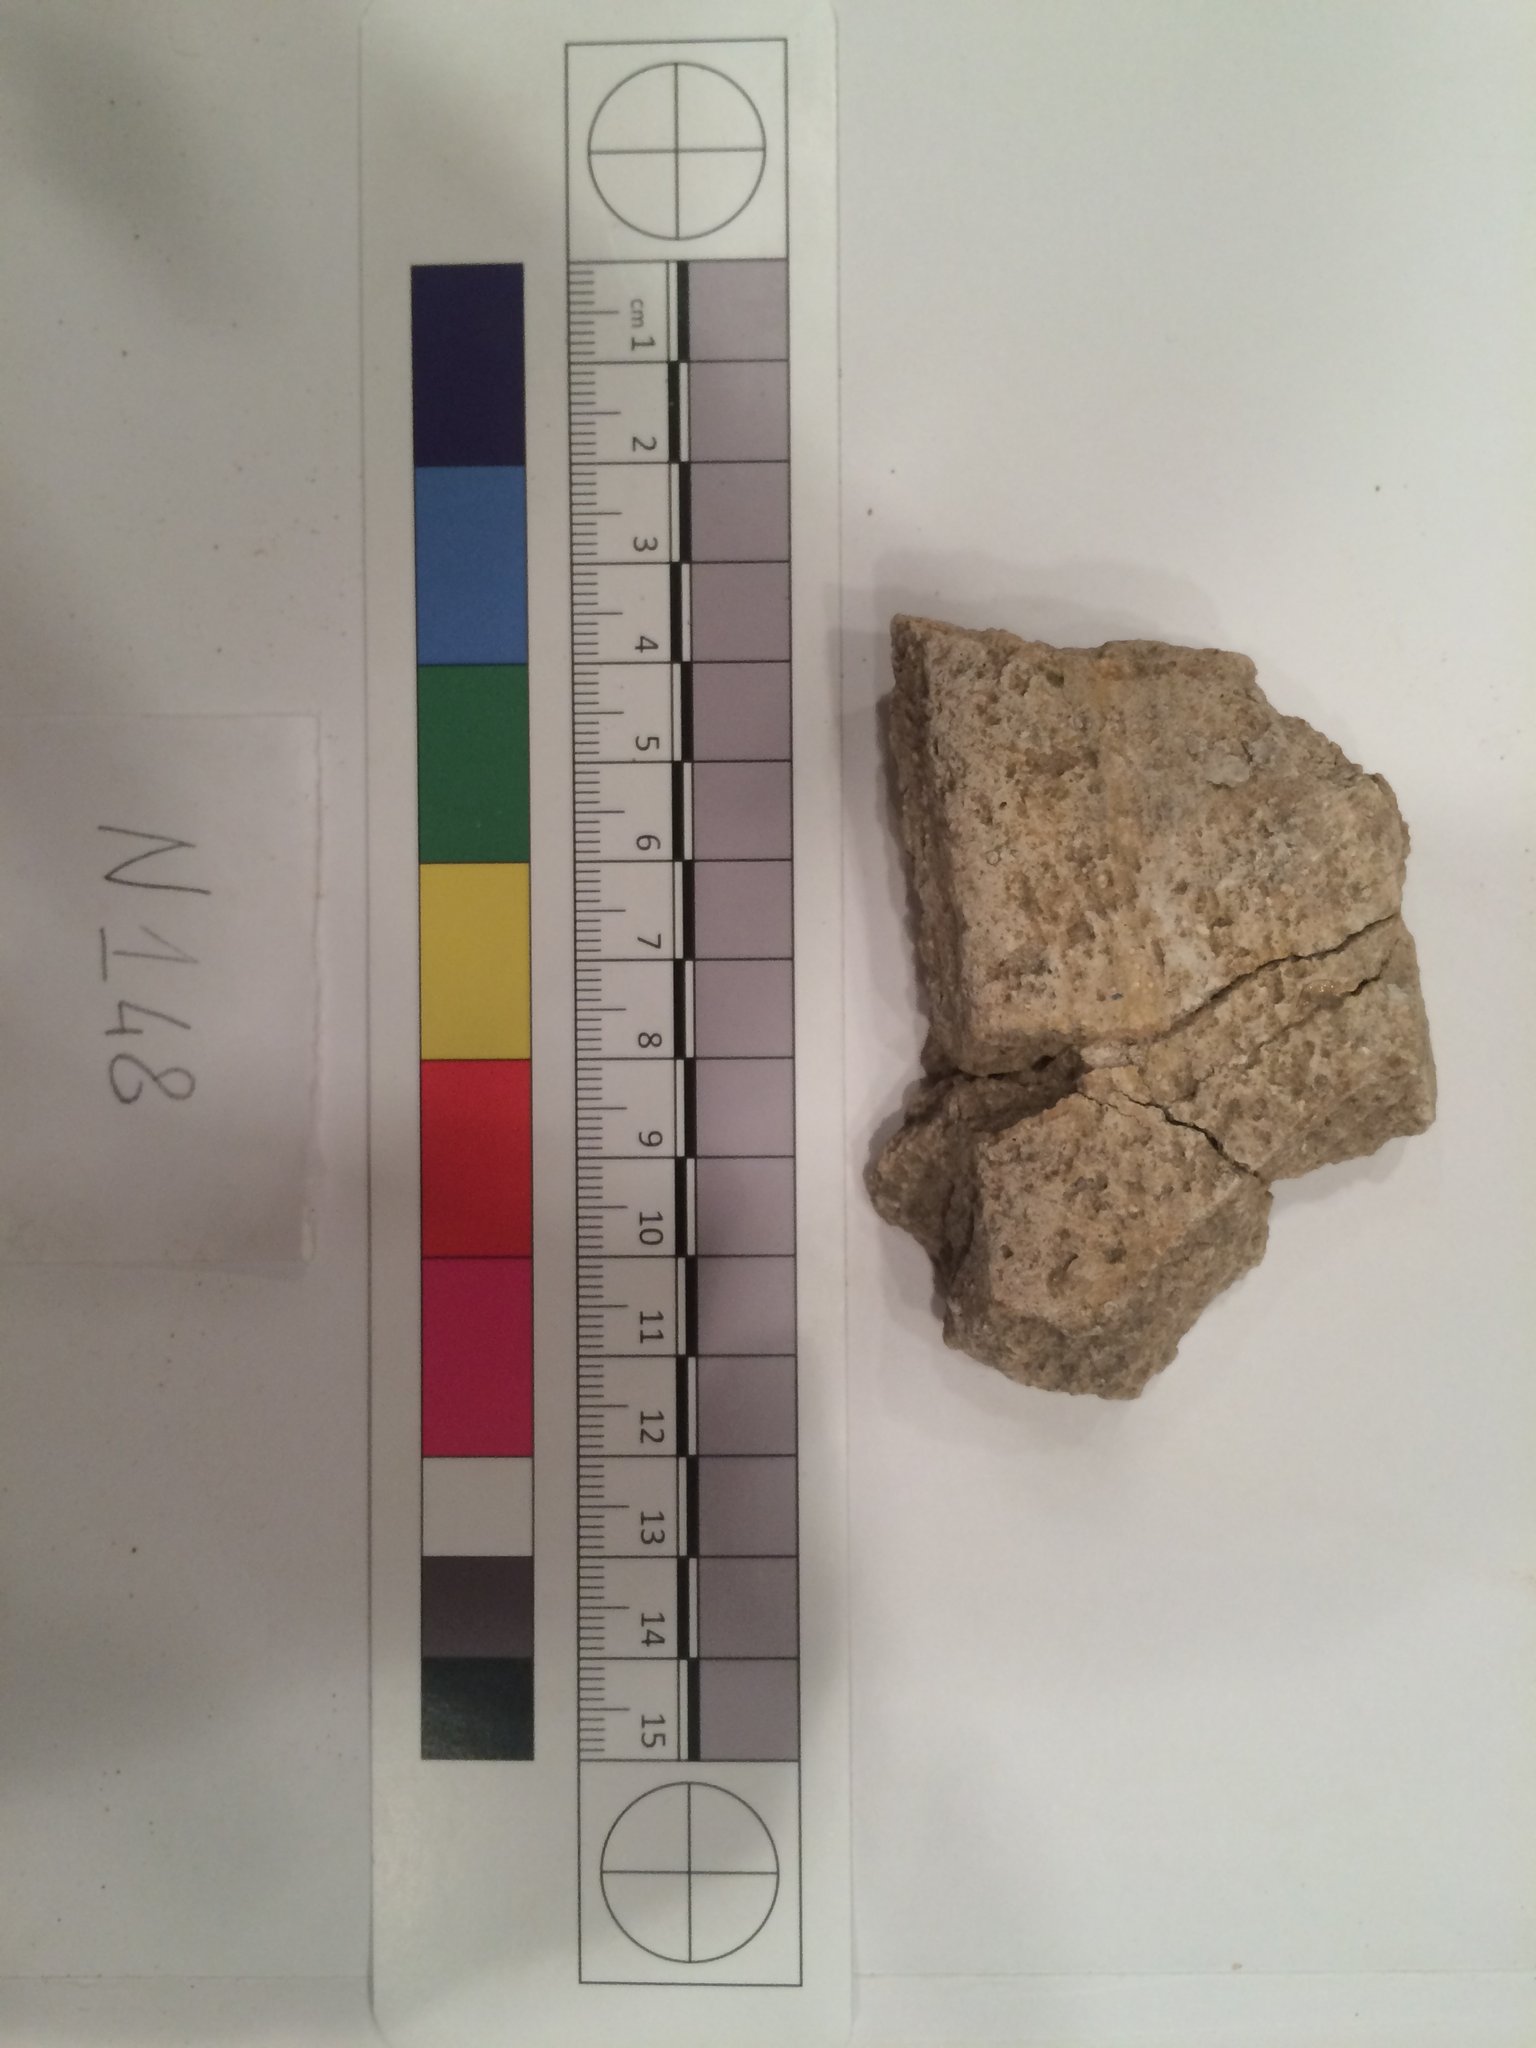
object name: fragment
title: Stucco Fragment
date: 701-1200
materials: plaster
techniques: carving, painting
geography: iran